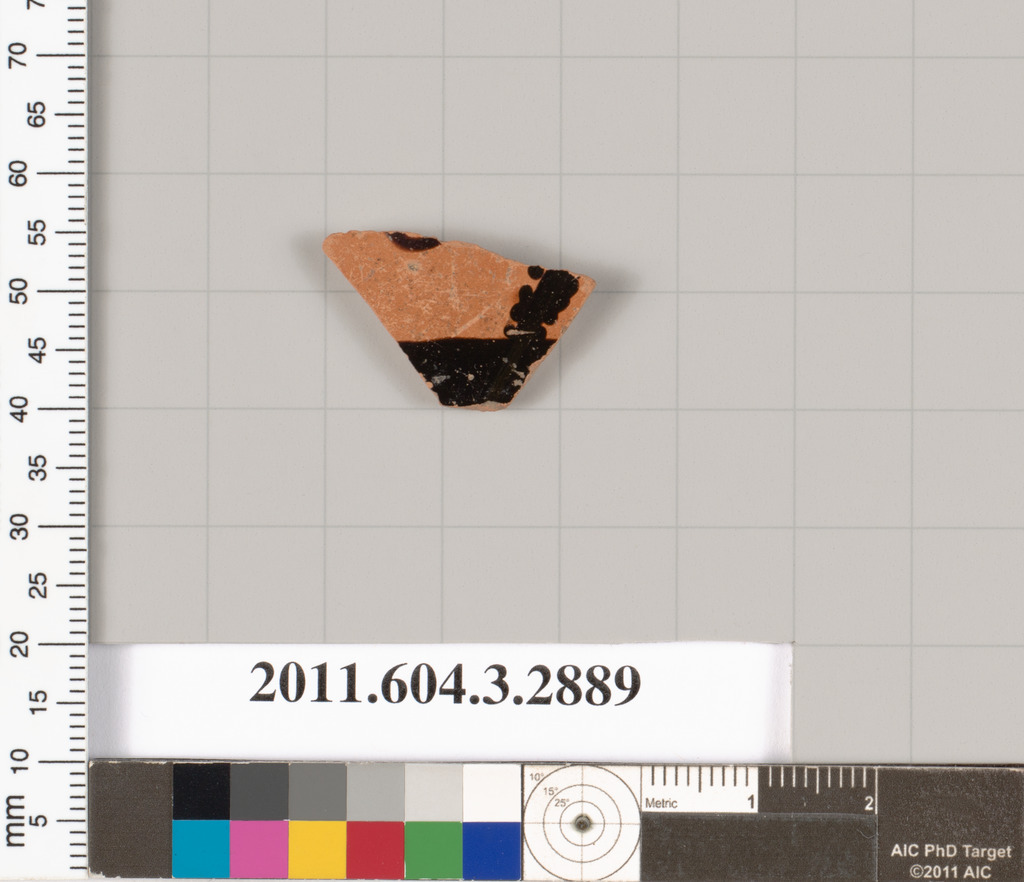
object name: oinochoe fragment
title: Terracotta fragment of an oinochoe (jug)?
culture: greek, attic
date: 600-401 BCE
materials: terracotta